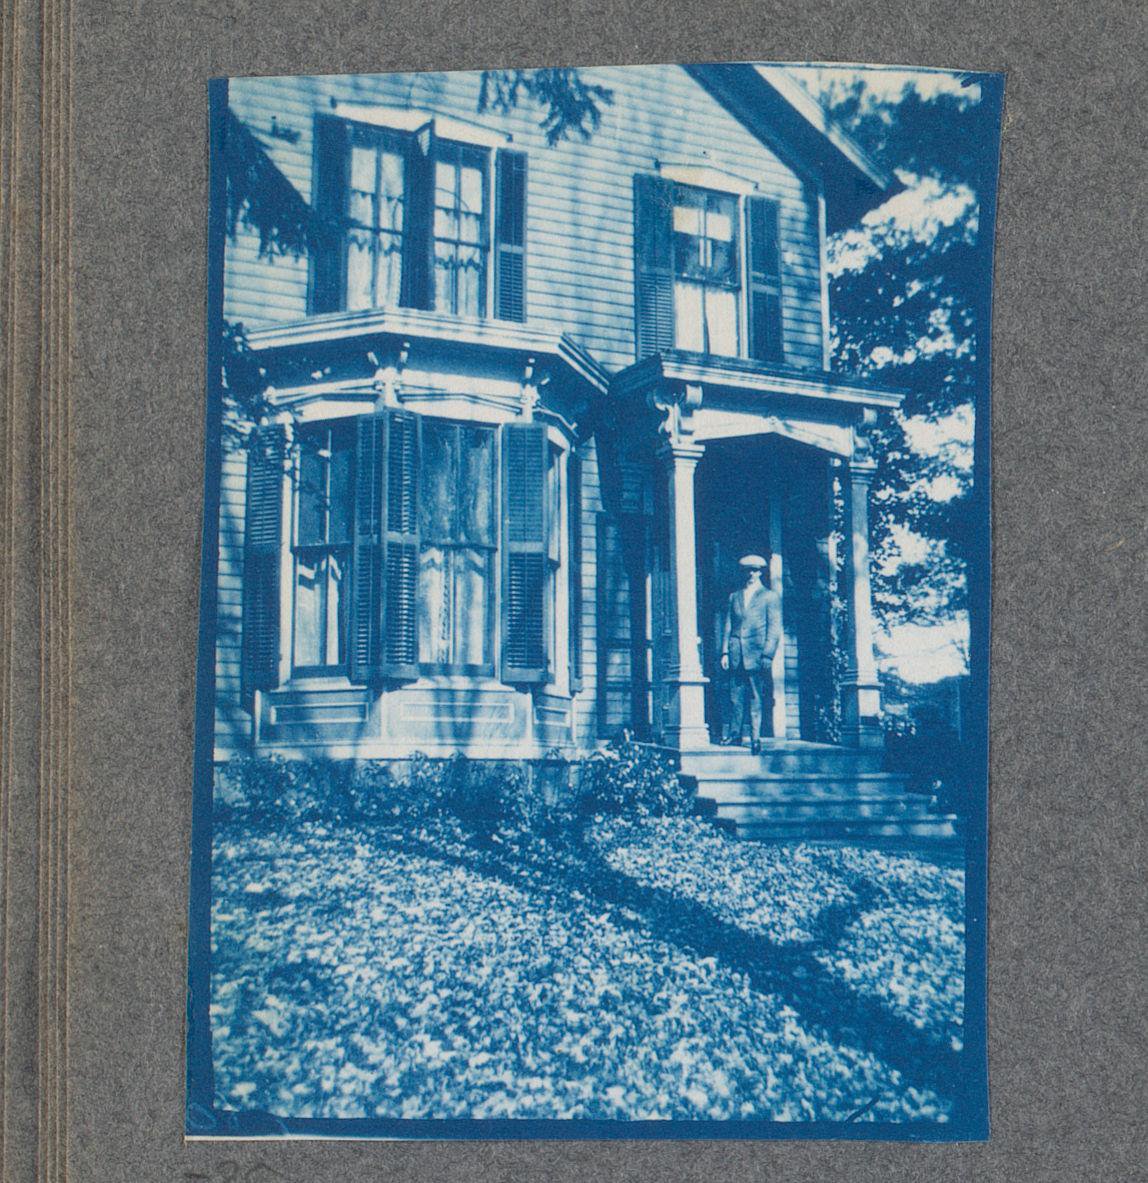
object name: album leaf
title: Jonge man voor een woning, mogelijk op de campus van Denison University in Ohio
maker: Anonymous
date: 1910-1920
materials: paper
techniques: cyanotype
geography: granville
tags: student